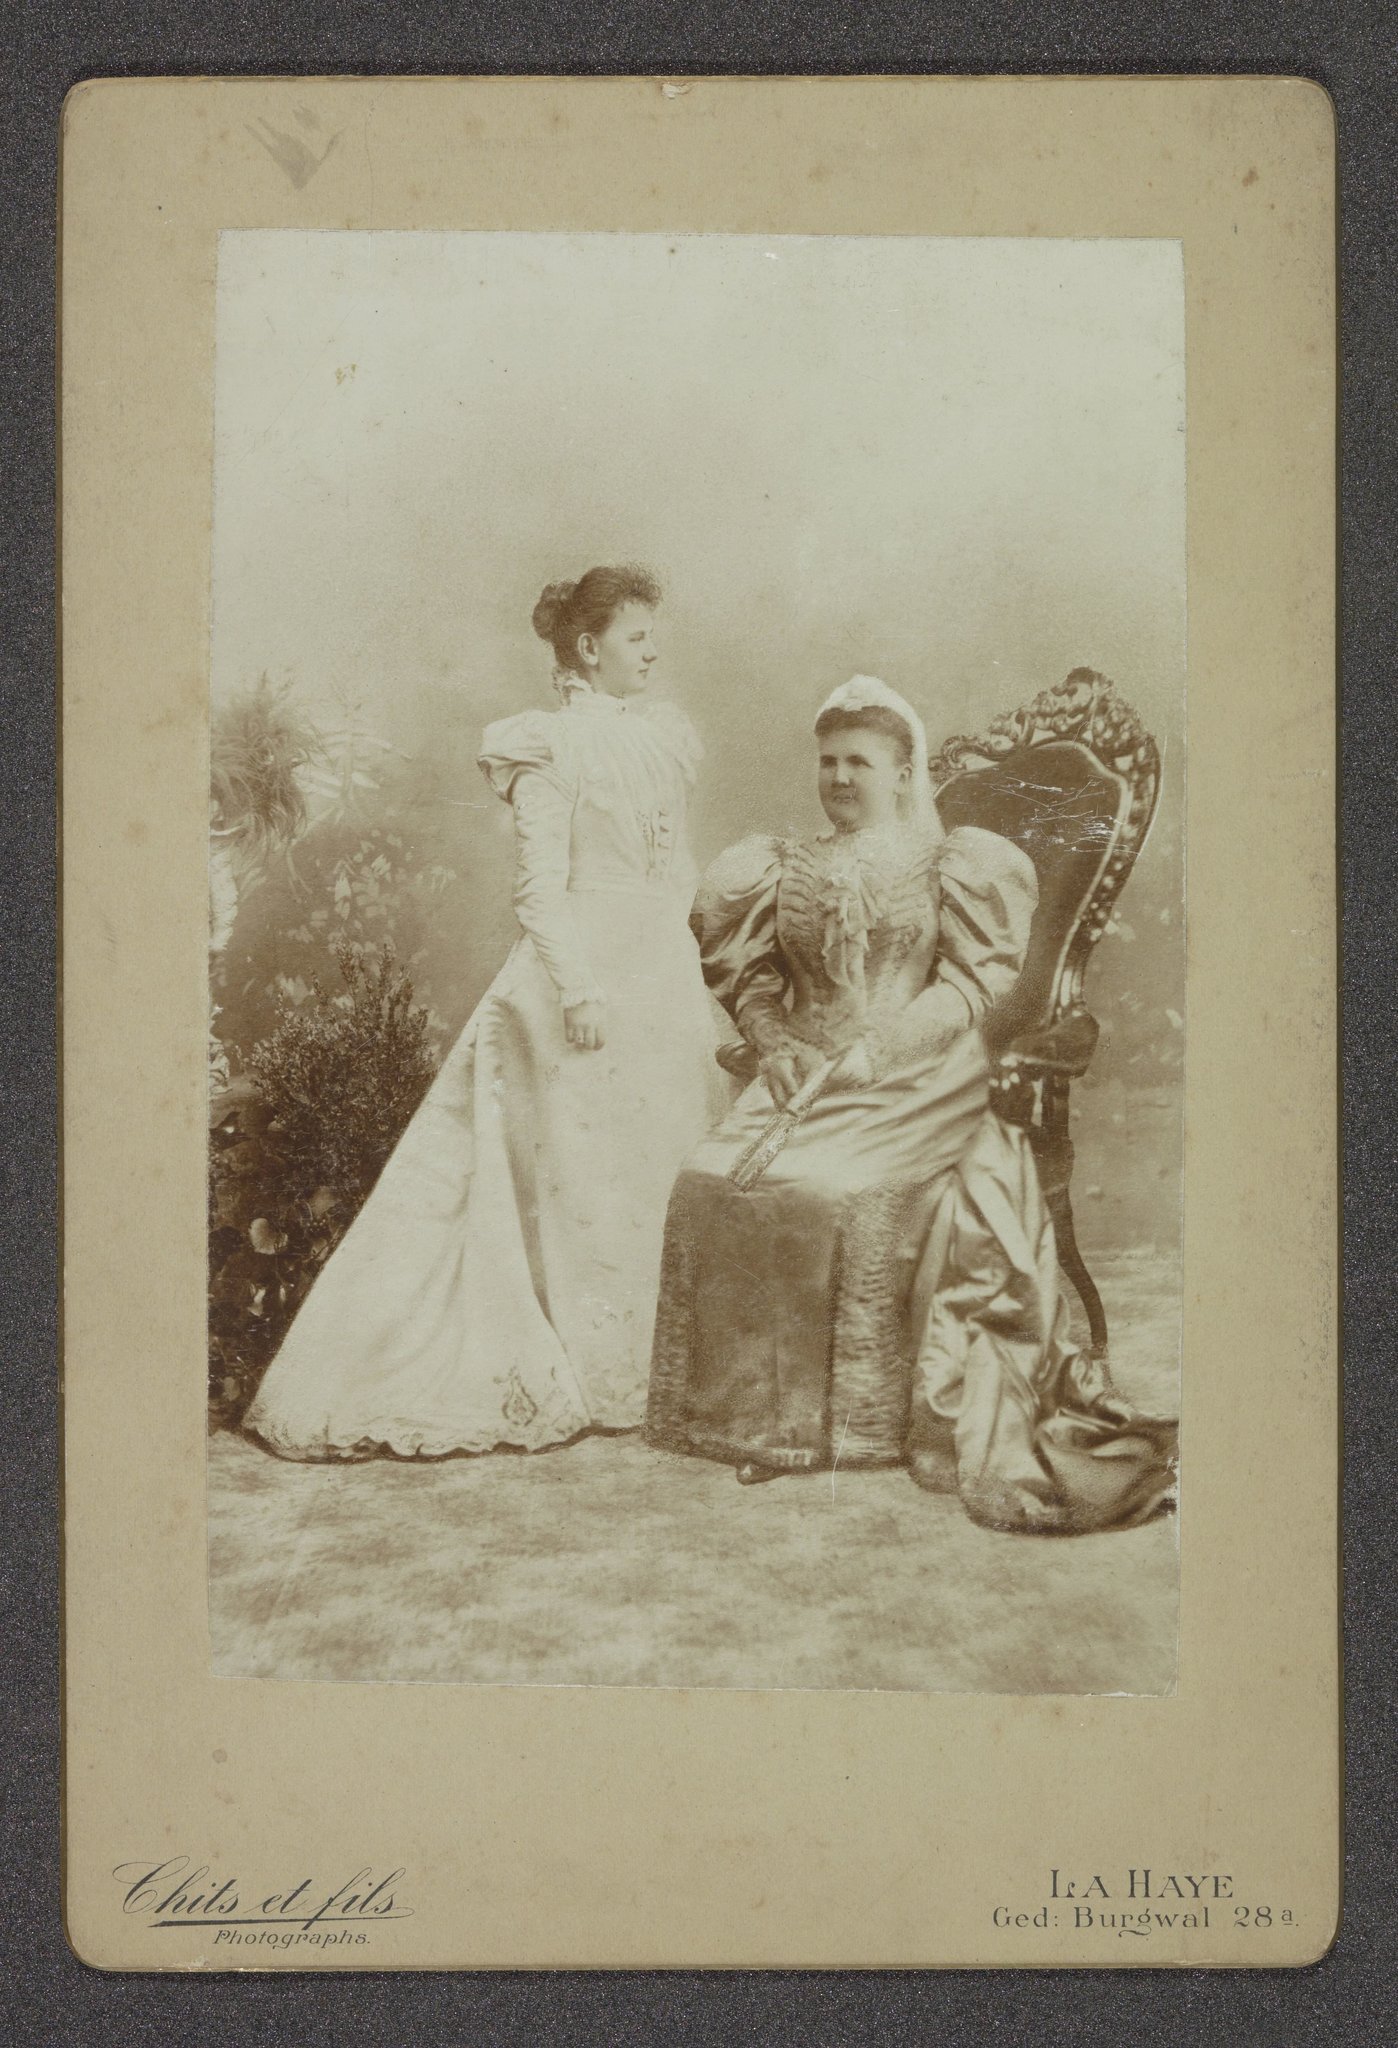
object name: photograph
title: Portret van Koningin Wilhelmina en haar Moeder koningin Emma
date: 1897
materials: cardboard, photographic support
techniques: collodion silver print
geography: the hague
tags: print maker, wilhelmina of the netherlands, the hague, emma (queen consort of the netherlands)